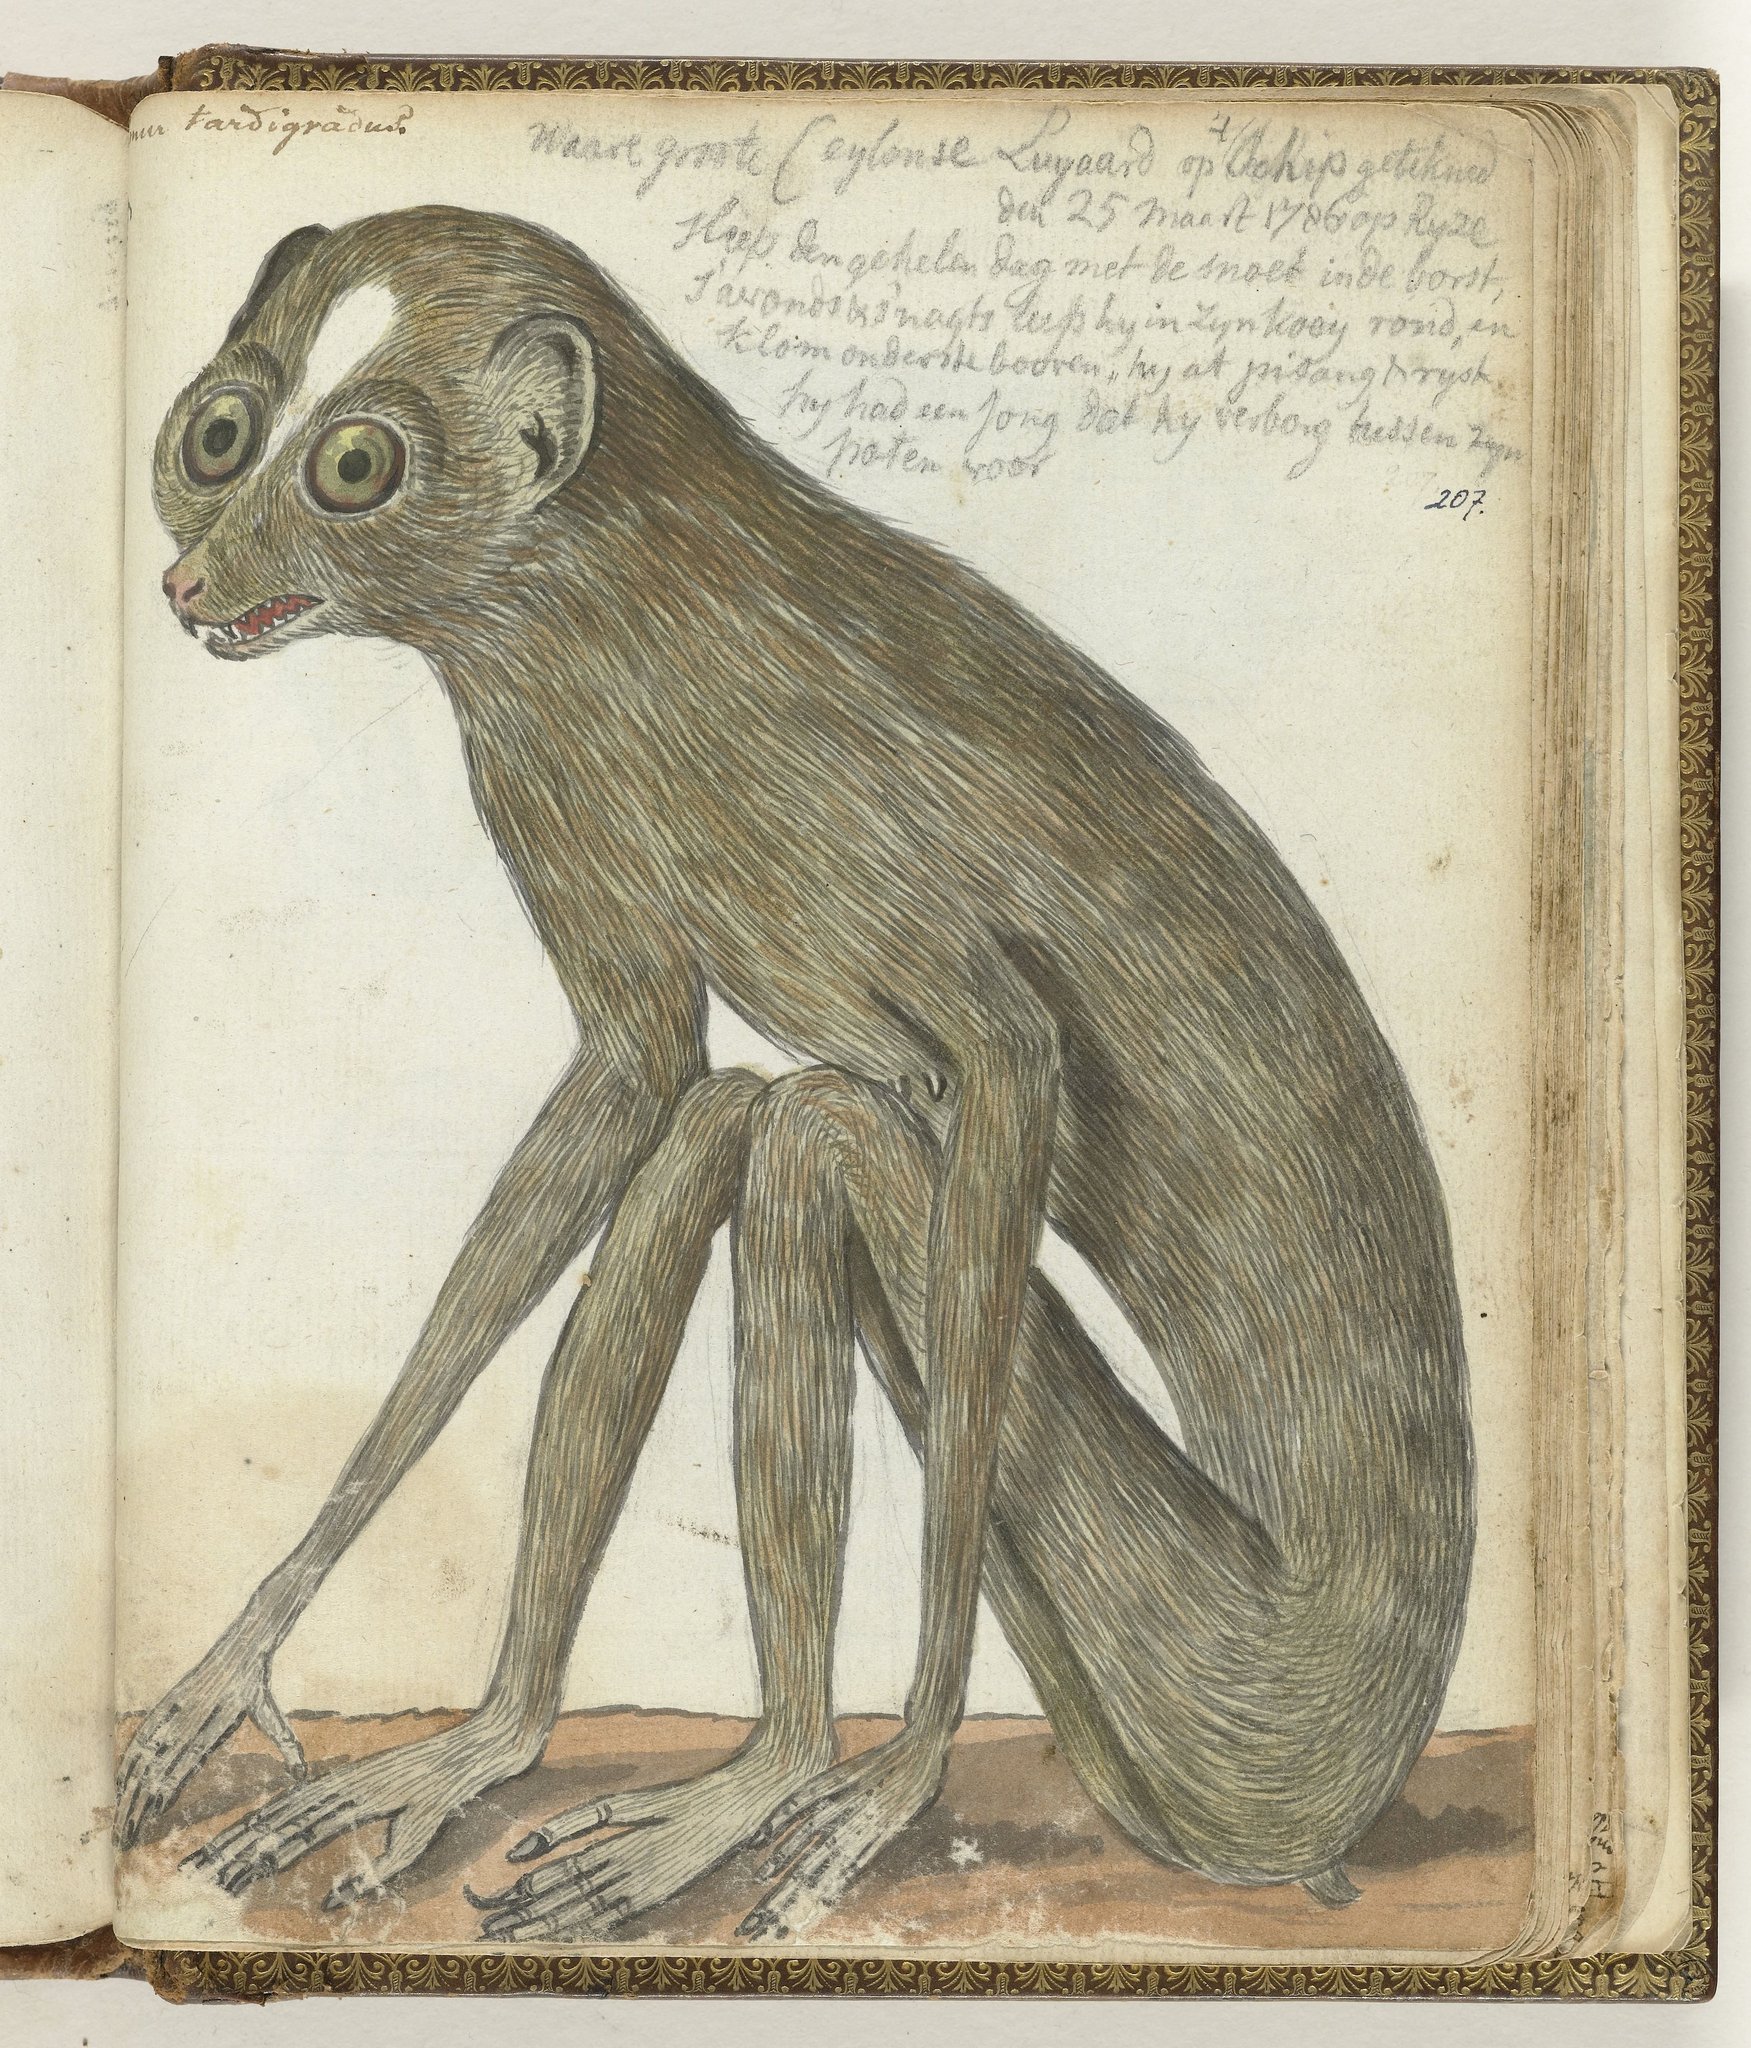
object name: drawing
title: Ceylonse luiaard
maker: jan brandes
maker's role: draughtsman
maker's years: 1743-1808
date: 1786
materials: paper, pencil, watercolor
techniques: brush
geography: indian ocean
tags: mammals, sri lanka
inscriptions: inscription: ‘Lemur tardigradus. / waare groote Ceylonse Luyaard op 't schip getekend den 25 maart 1786 op Ryze sliep den gehelen dag met de snoet in de borst, s'avonds & s'nagts liep hy in zyn kooy rond, en klom onderste booven, hij at pisang & ryst. hy had een jong dat hy verborg tussen zyn poten voor’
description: Kleurtekening van een luiaard van Ceylon. Met opschrift. Onderdeel uit het schetsboek van Jan Brandes, dl. 1 (1808), p. 207.